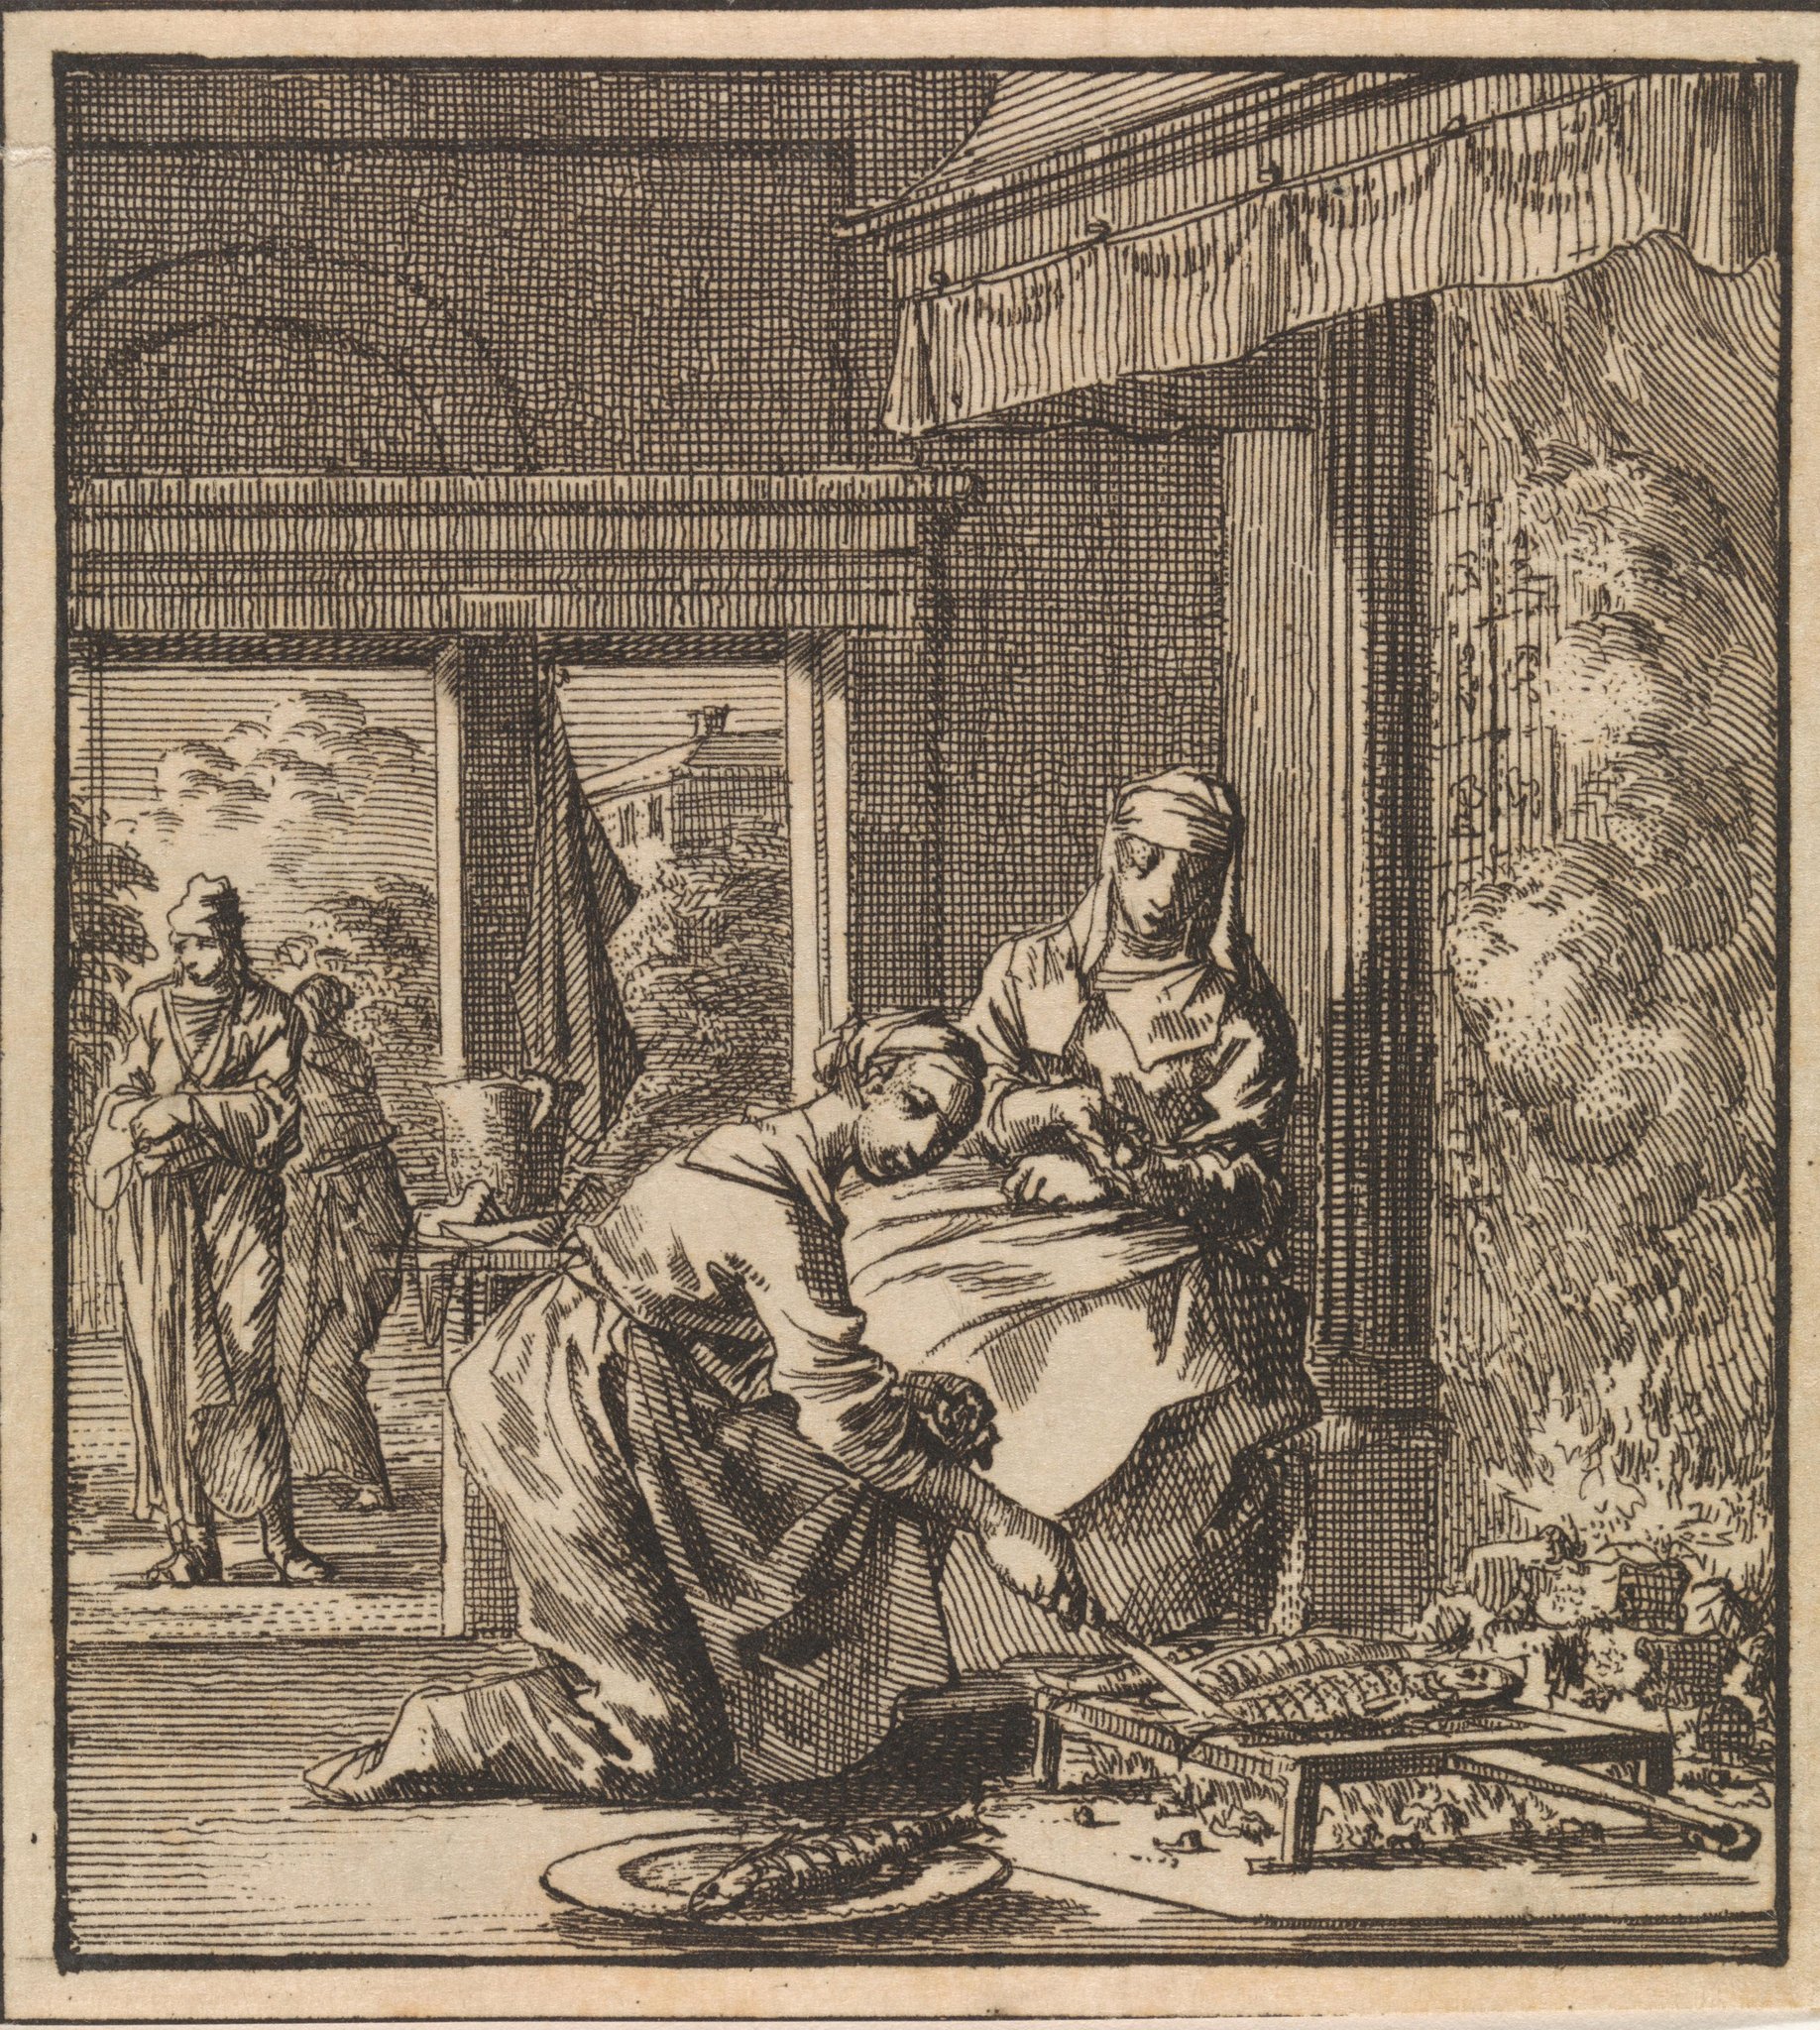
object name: print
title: De Rooster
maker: jan luyken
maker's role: draughtsman, print maker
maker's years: 1649-1712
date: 1711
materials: paper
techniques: etching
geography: amsterdam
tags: chimney, roasting, grilling, fishes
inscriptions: collector's mark: Lugt 2228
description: Proefdruk van illustratie voor: Luyken, Jan. Het leerzaam huisraad, vertoond in vyftig konstige figuuren, met godlyke spreuken en stichtelyke verzen: Pieter Arentsz. II (wed.) en Cornelis van der Sys, 1711, p. 134.